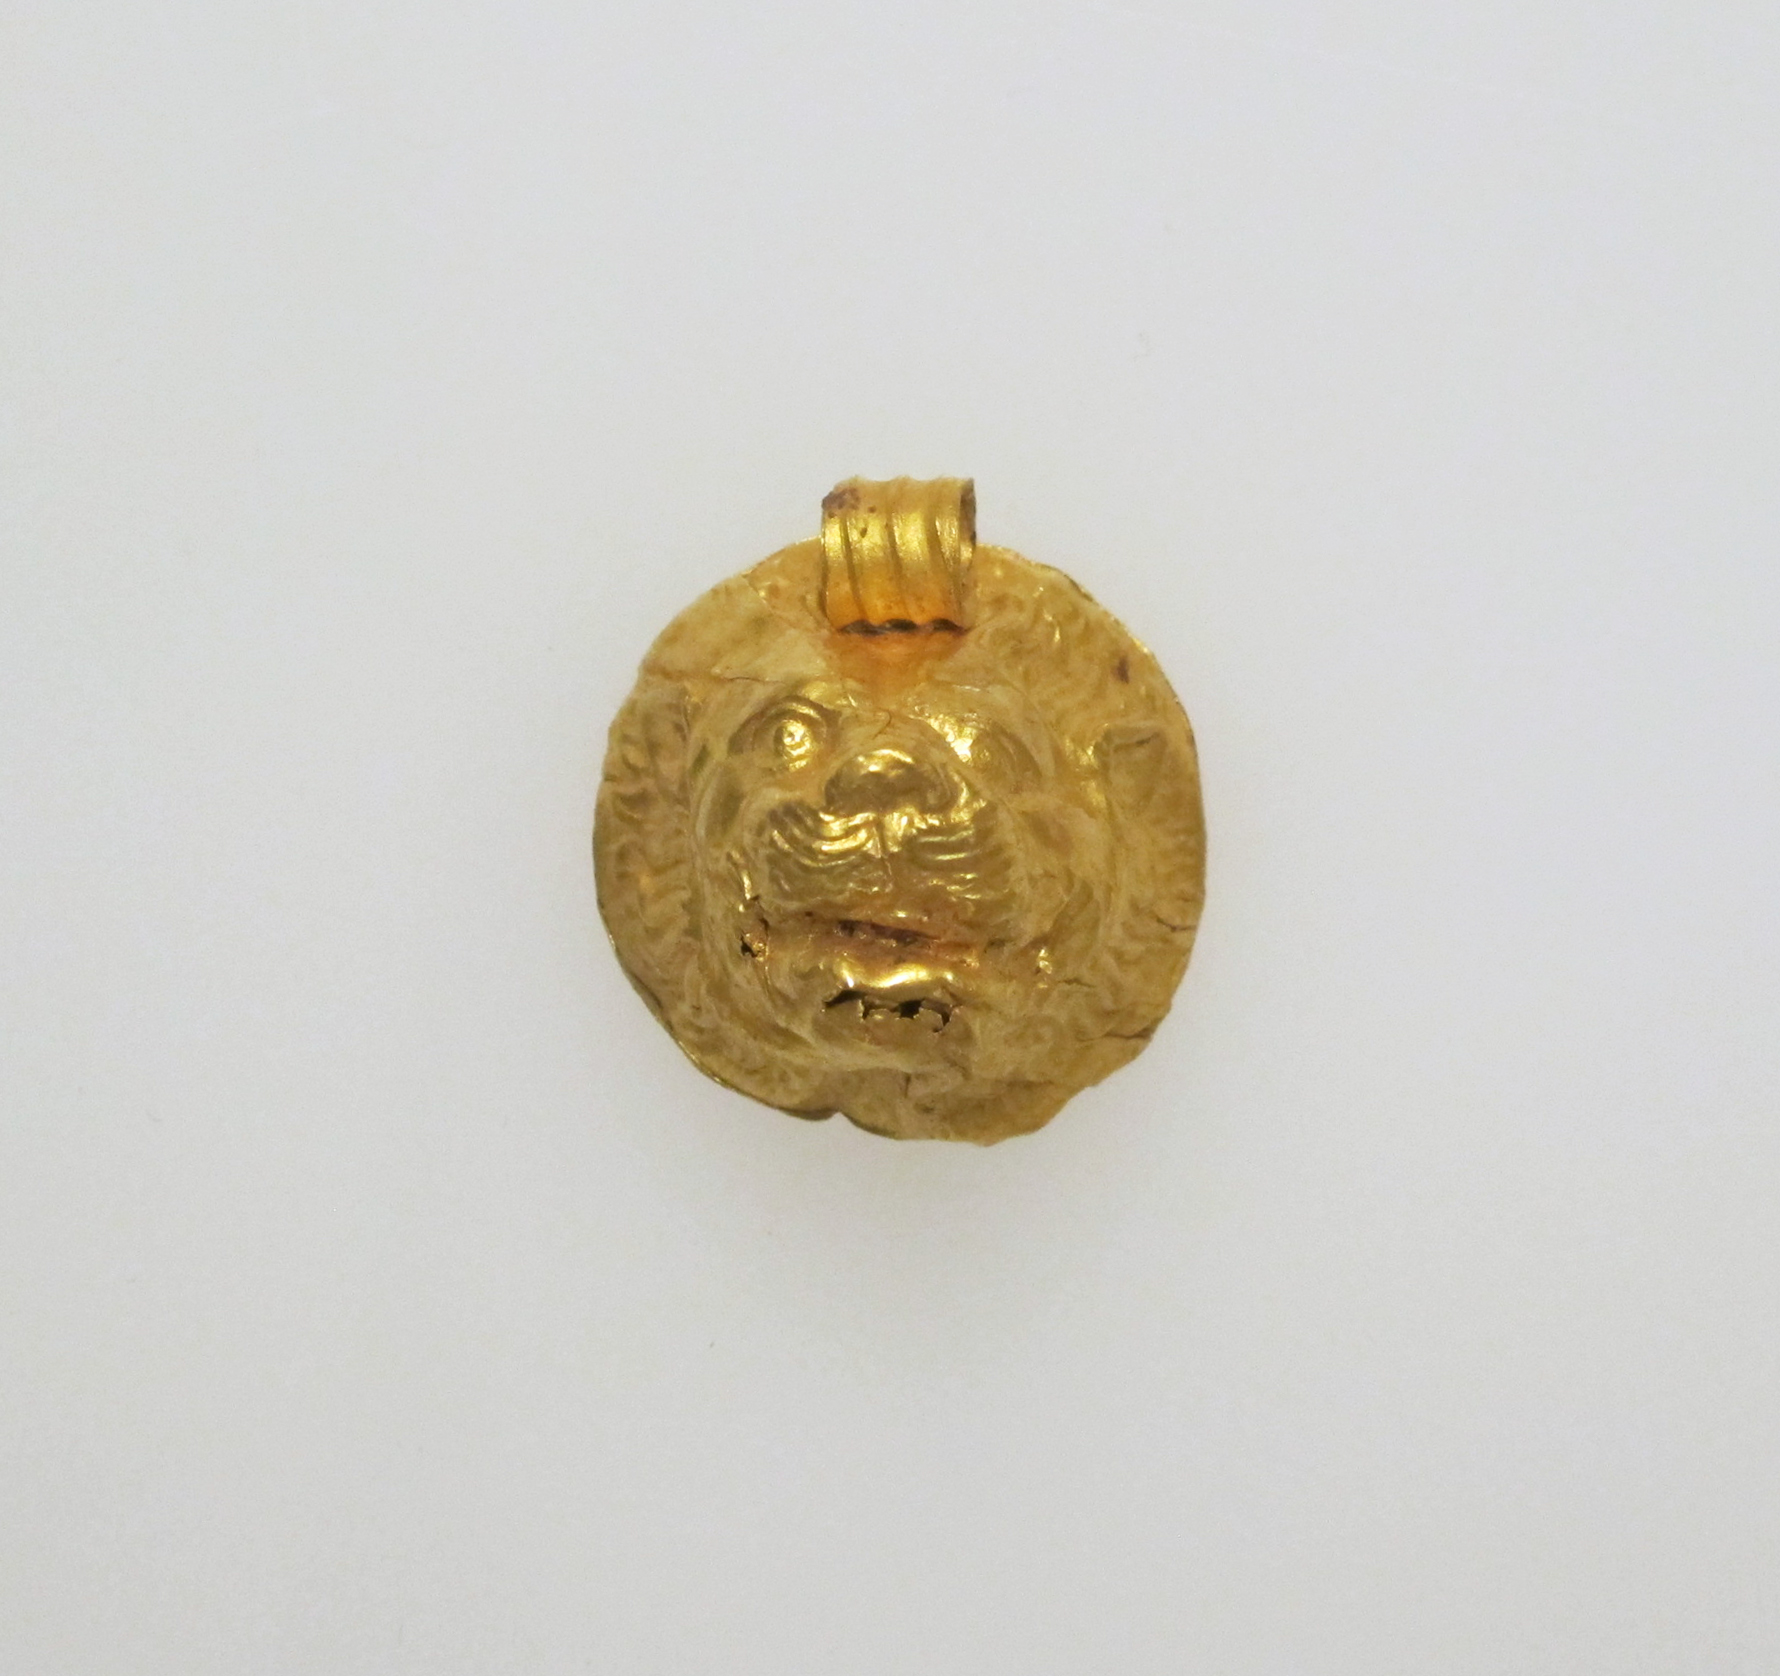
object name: pendant in the form of a lion's head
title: Pendant in the form a lion's head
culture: greek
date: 400-301 BCE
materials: gold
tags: lions